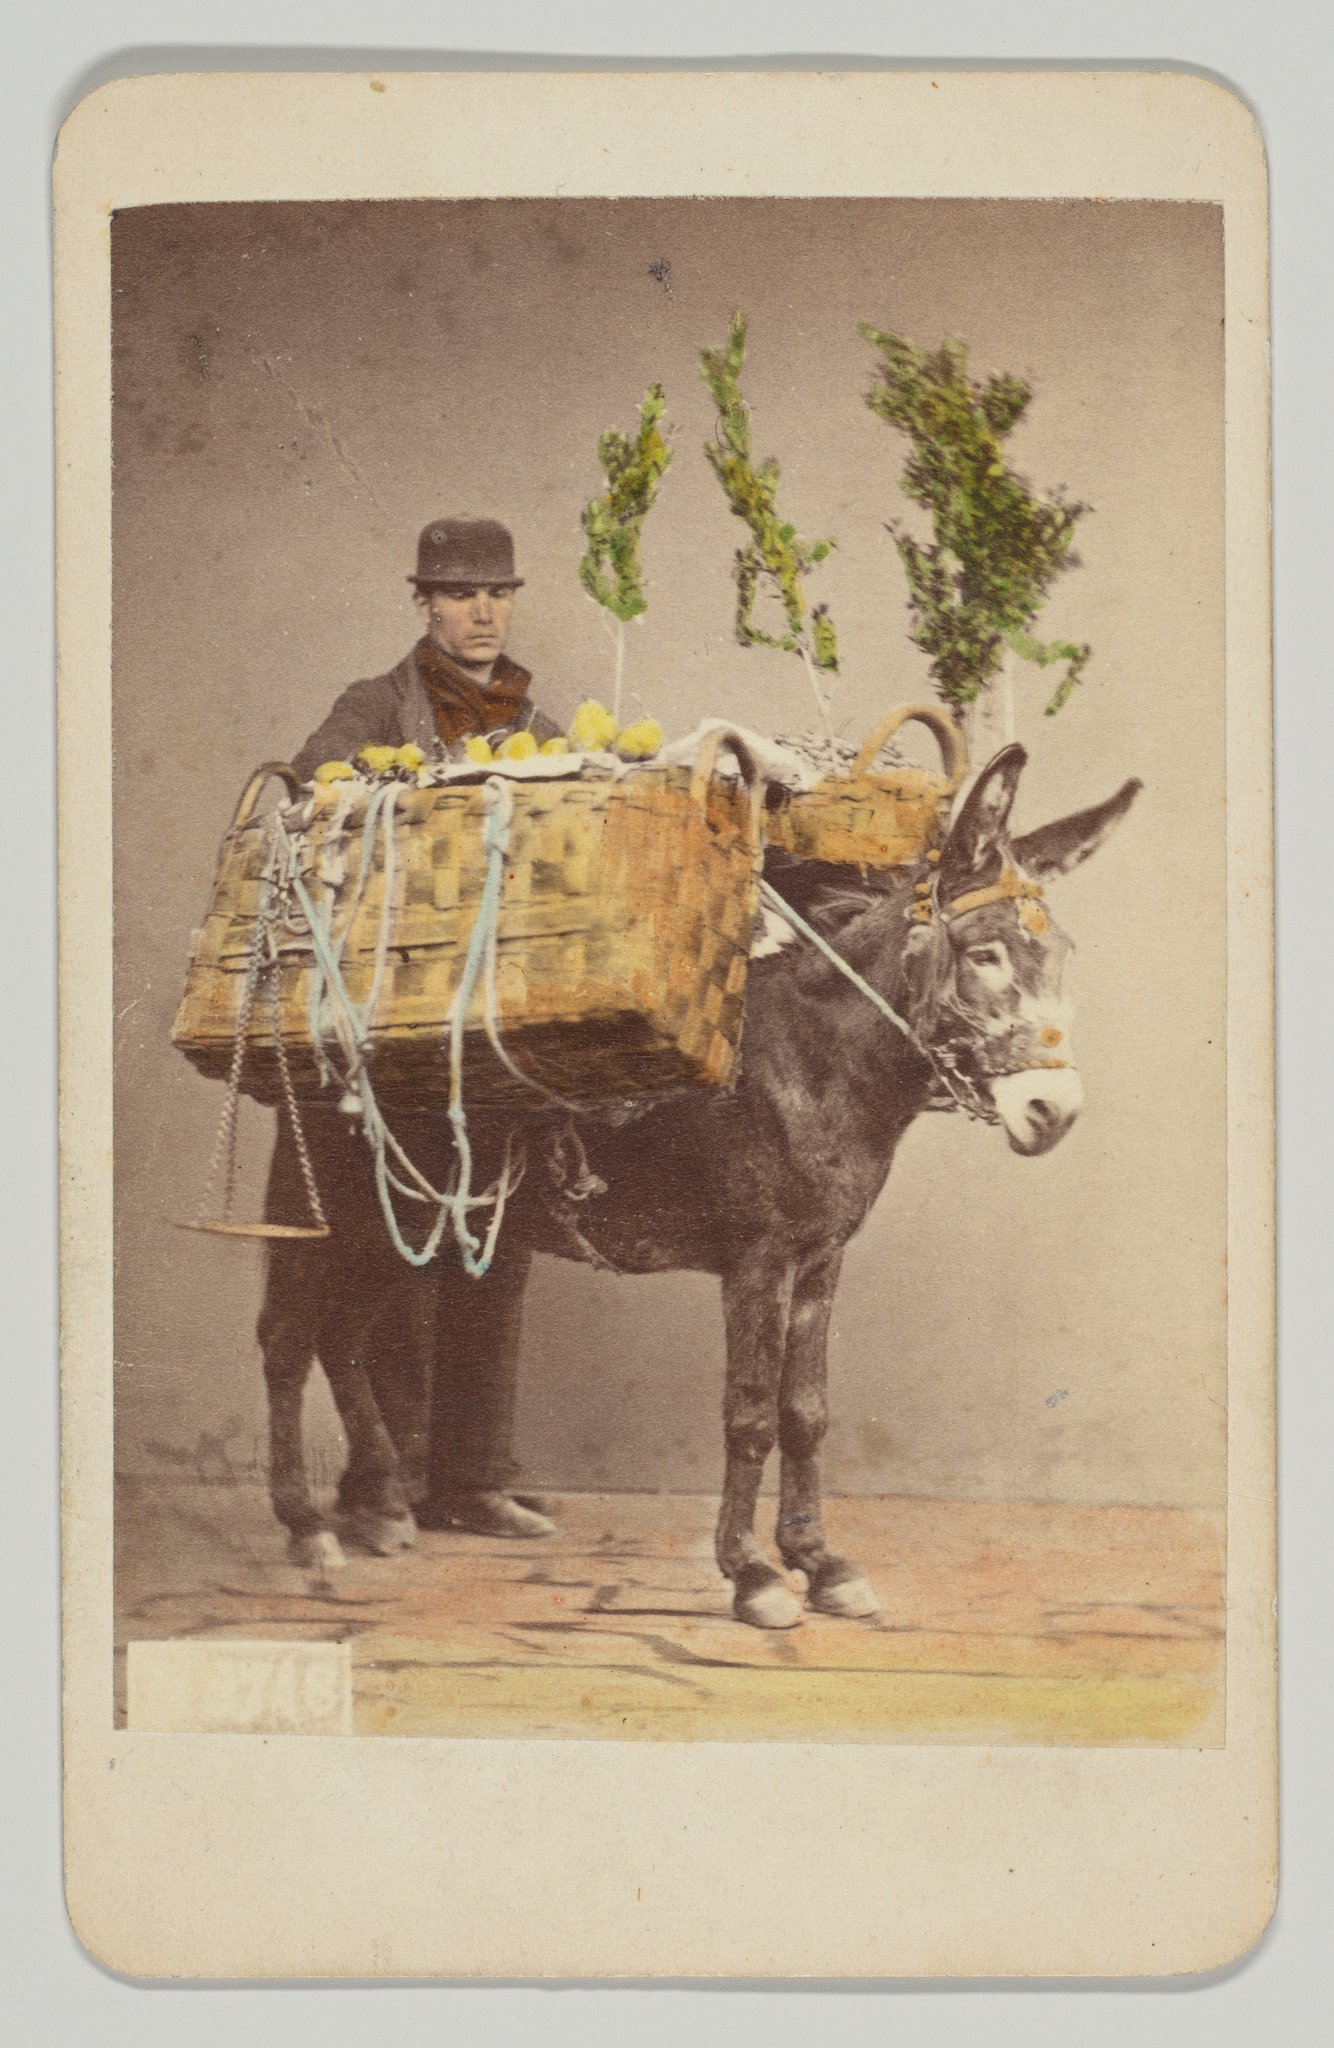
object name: carte de visite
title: [Neapolitan Folk Scene]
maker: giorgio sommer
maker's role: fotograaf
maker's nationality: italian, born germany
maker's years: 1834-1914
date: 1867-1873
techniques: albumen silver print